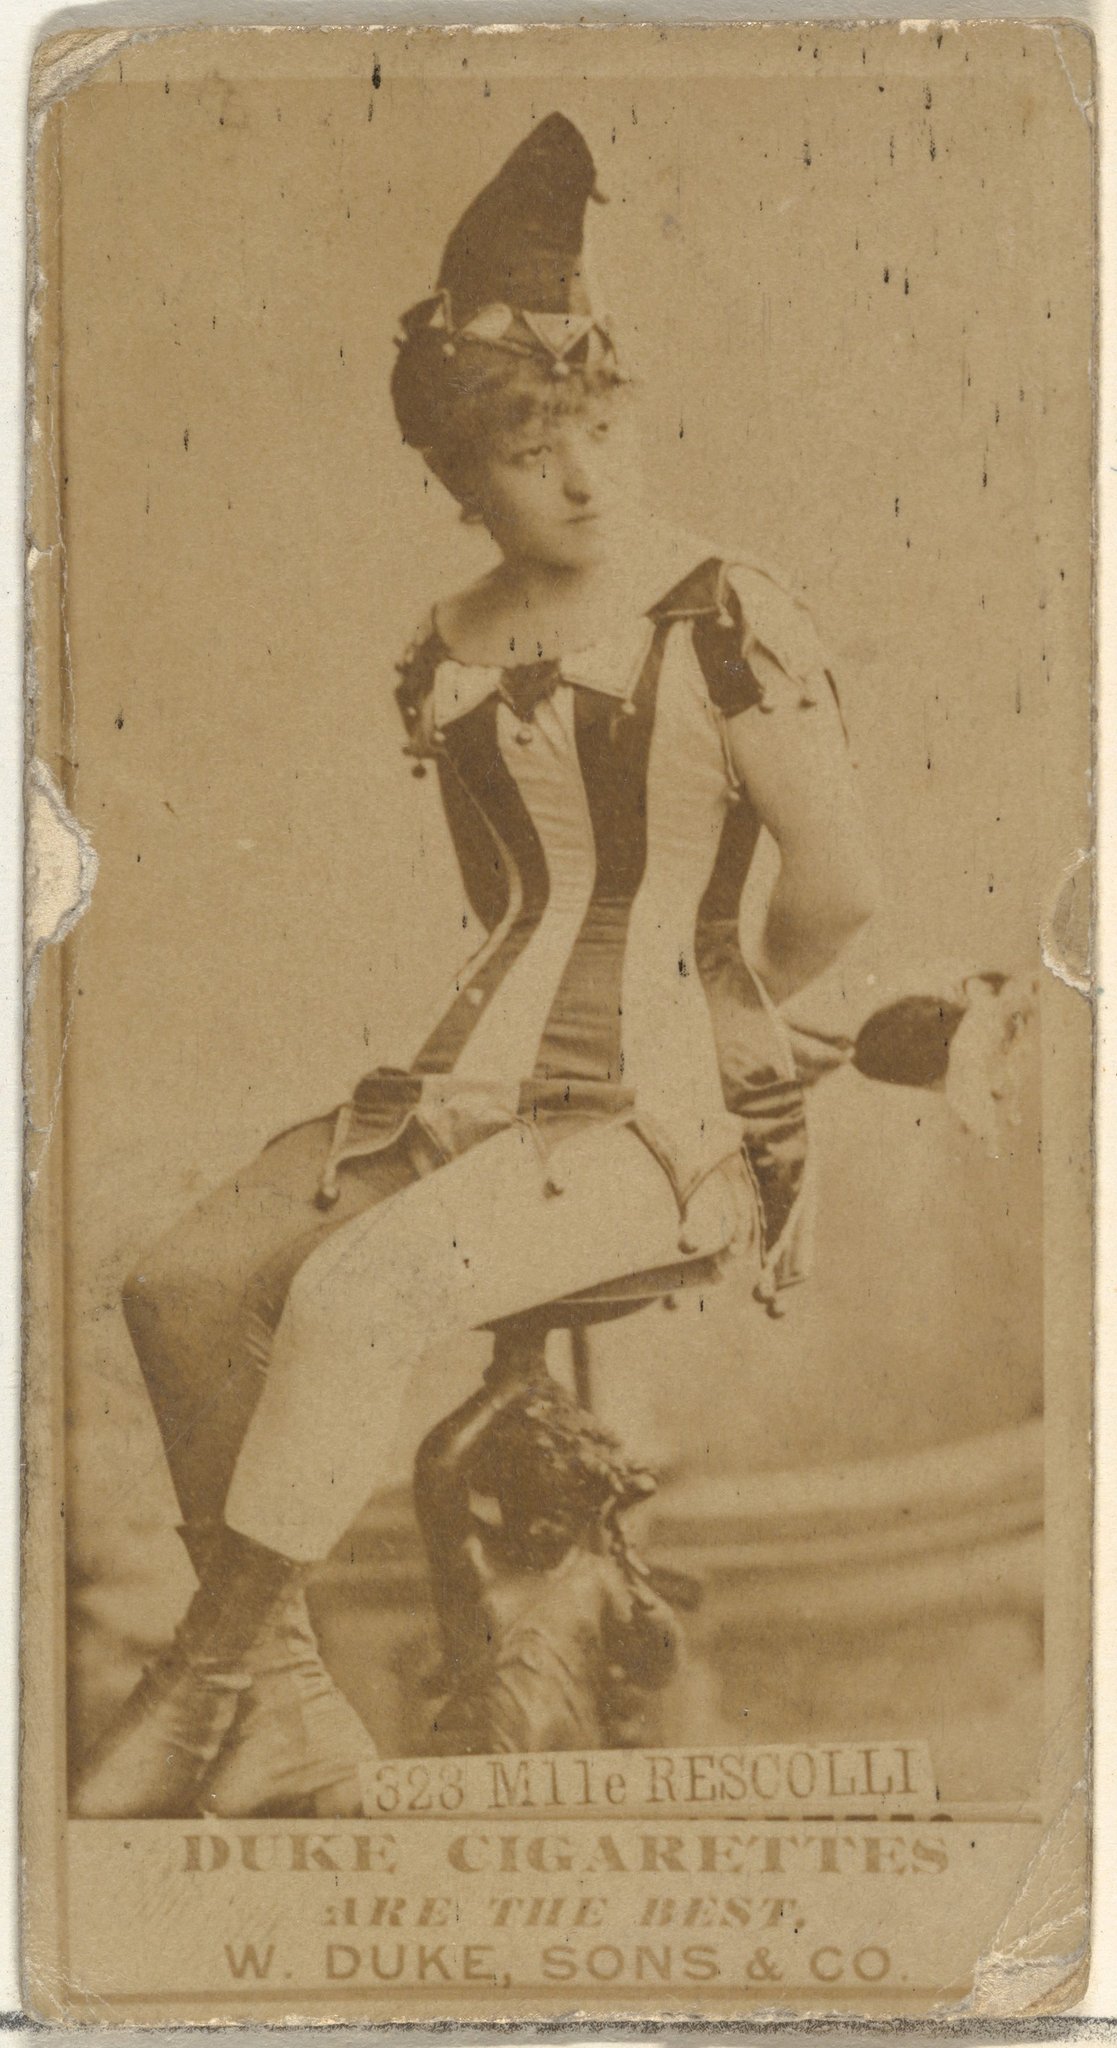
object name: photograph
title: Card Number 323, Mlle. Rescolli, from the Actors and Actresses series (N145-7) issued by Duke Sons & Co. to promote Duke Cigarettes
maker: w. duke, sons & co.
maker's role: publisher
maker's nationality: american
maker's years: 1870-1920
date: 1880-1889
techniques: albumen silver print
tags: portraits,women,actresses